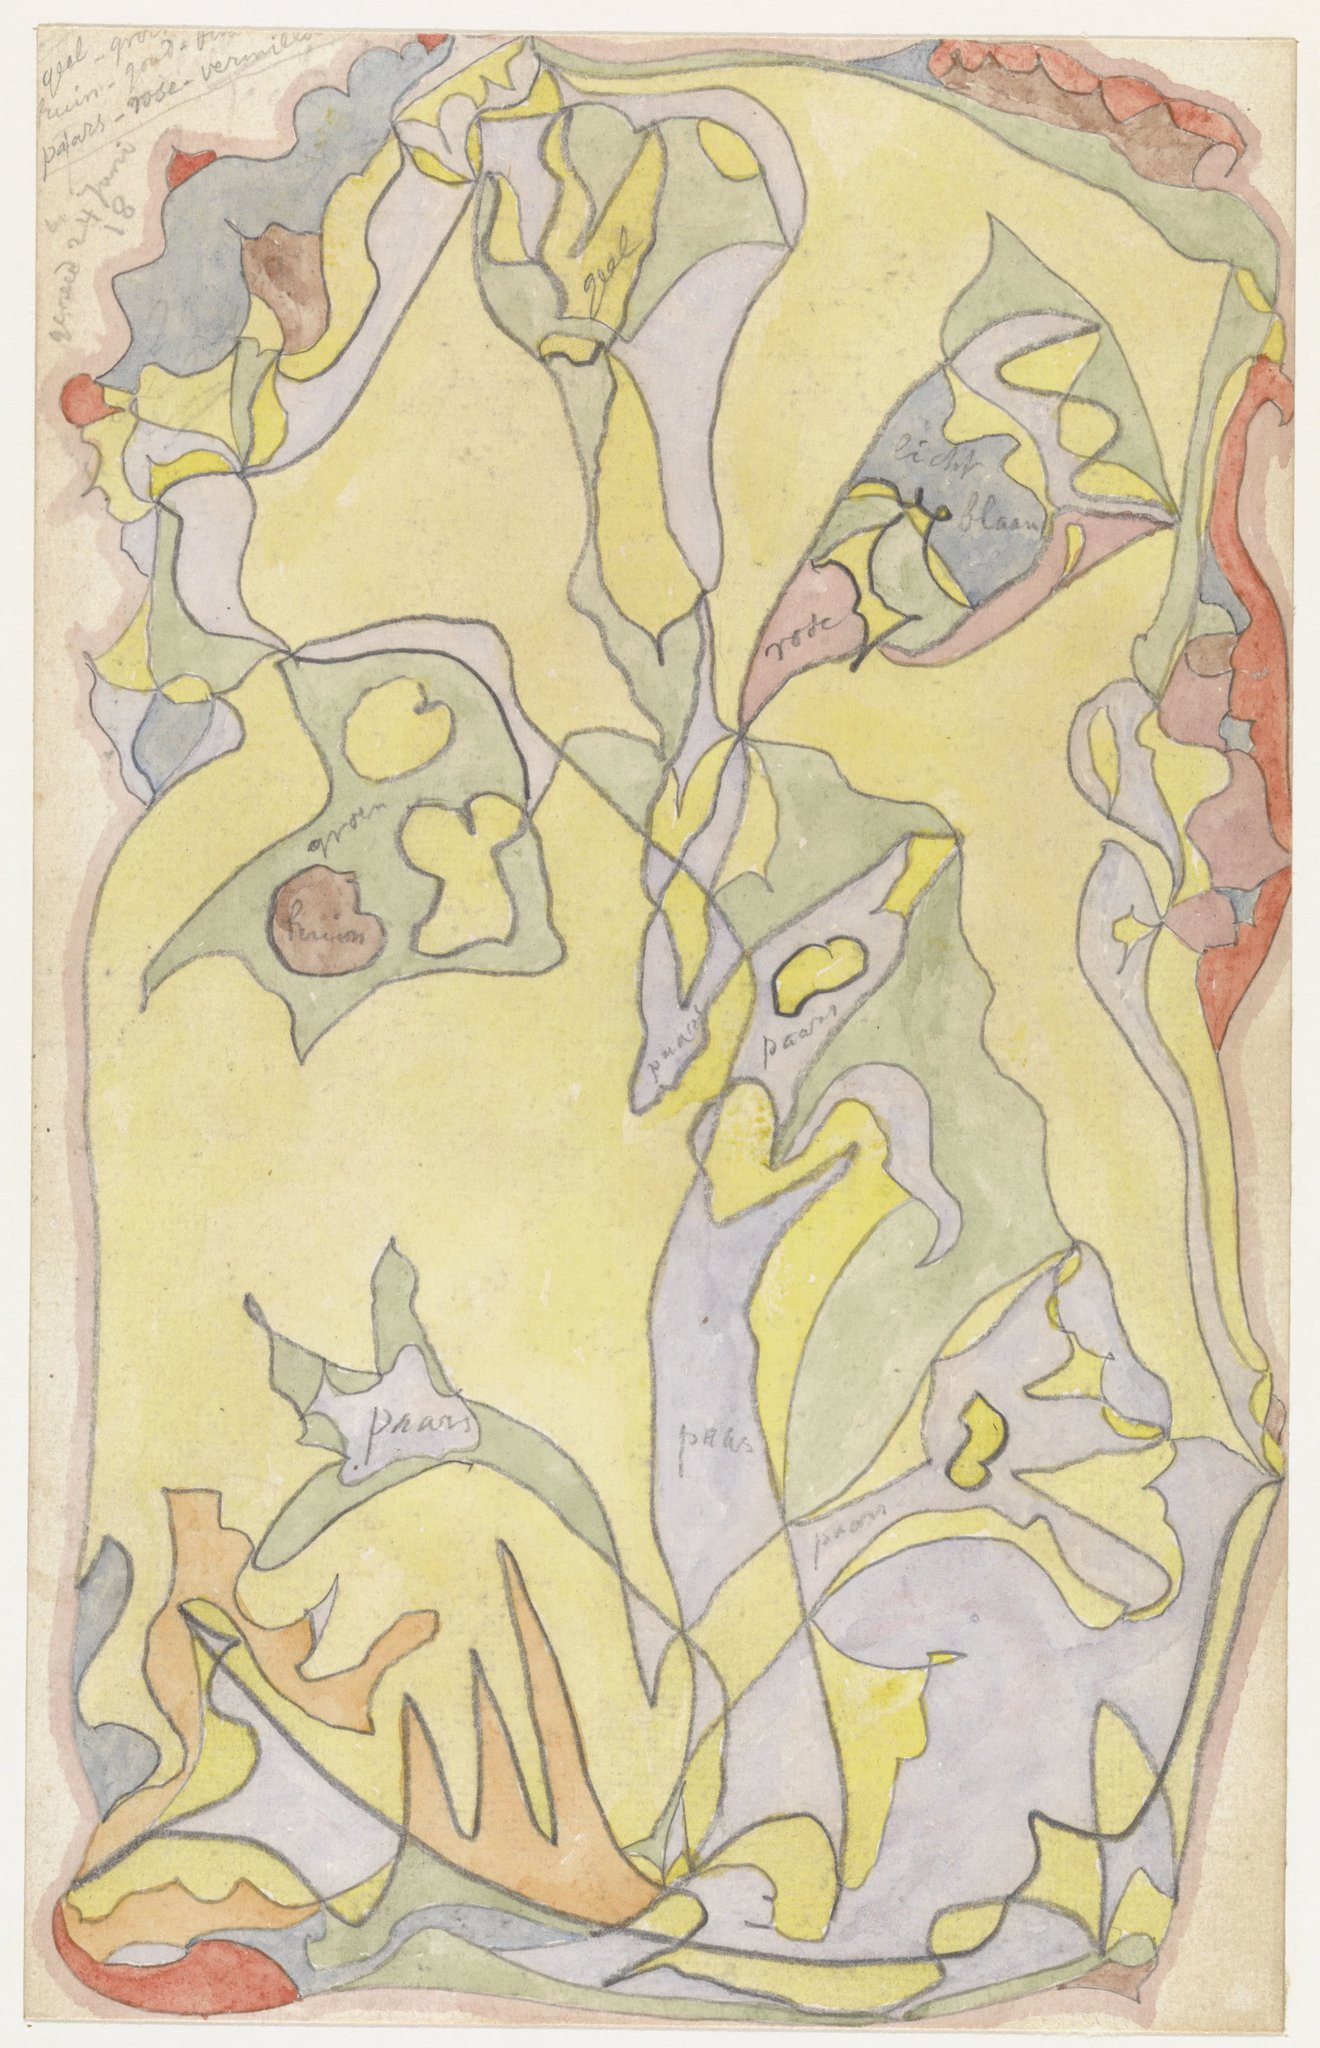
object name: drawing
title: Bloemmotieven op een geel fond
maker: theo colenbrander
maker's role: draughtsman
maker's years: 1841-1930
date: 1918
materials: paper, pencil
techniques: brush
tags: unidentifiable plant forms ~ ornament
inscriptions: date: ‘gereed 24 Juni 18’